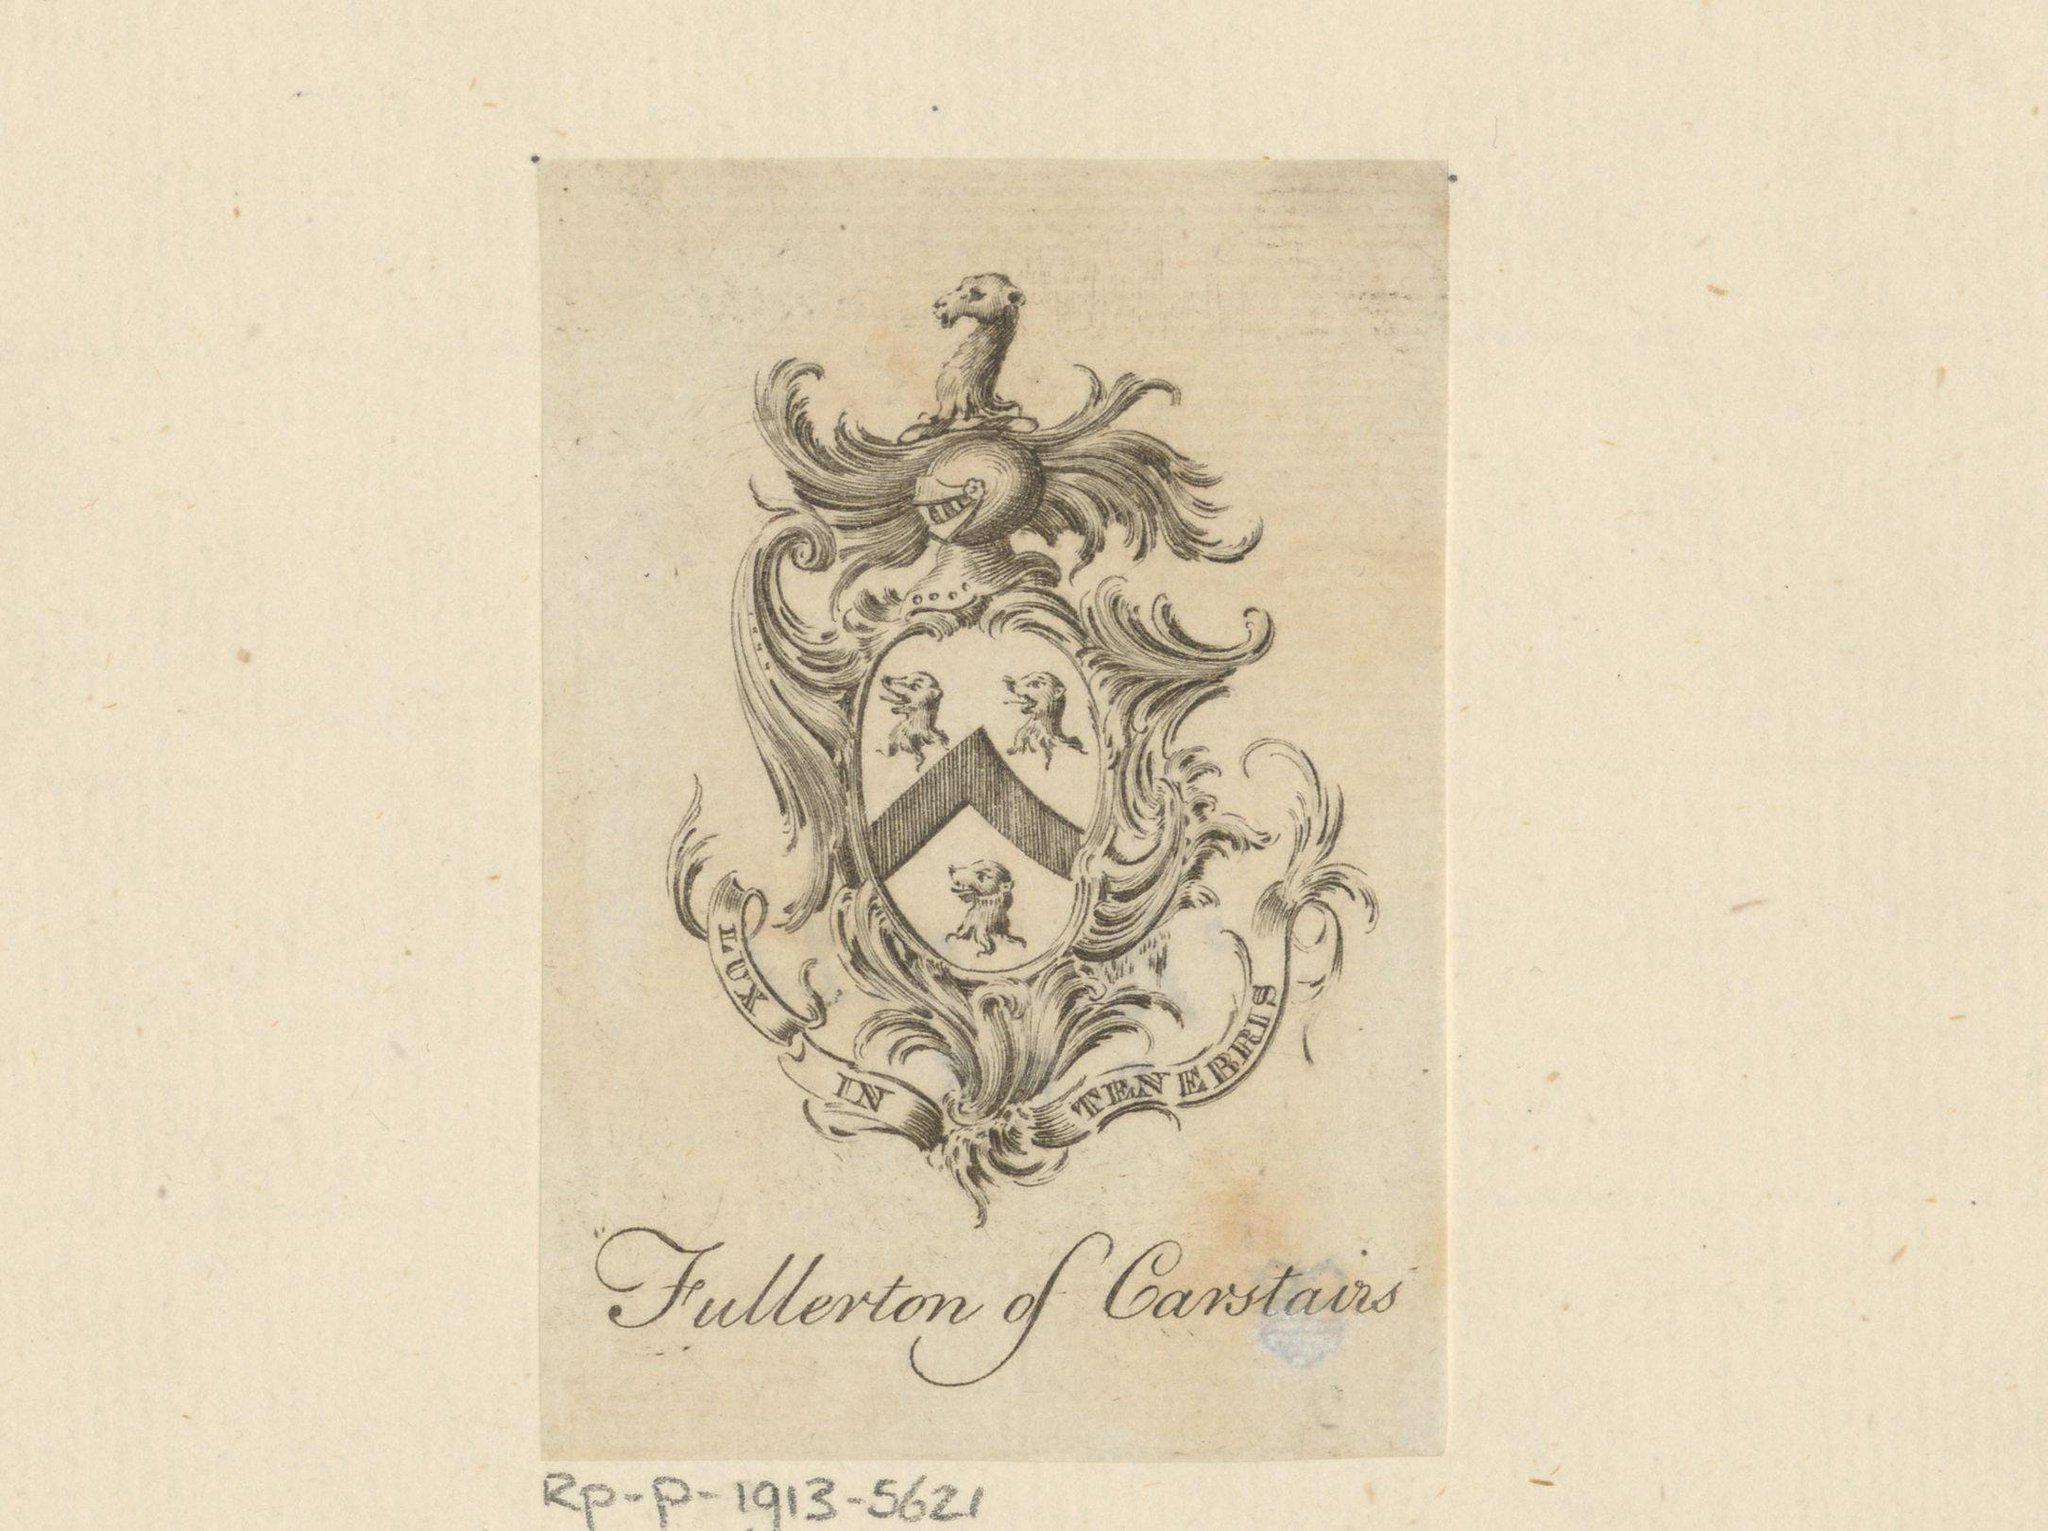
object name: bookplate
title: Ex libris van Fullerton of Carstairs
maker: Anonymous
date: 1700-1799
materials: paper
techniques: engraving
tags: armorial bearing, heraldry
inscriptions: collector's mark: Lugt 2760, collector's mark: Lugt 2233